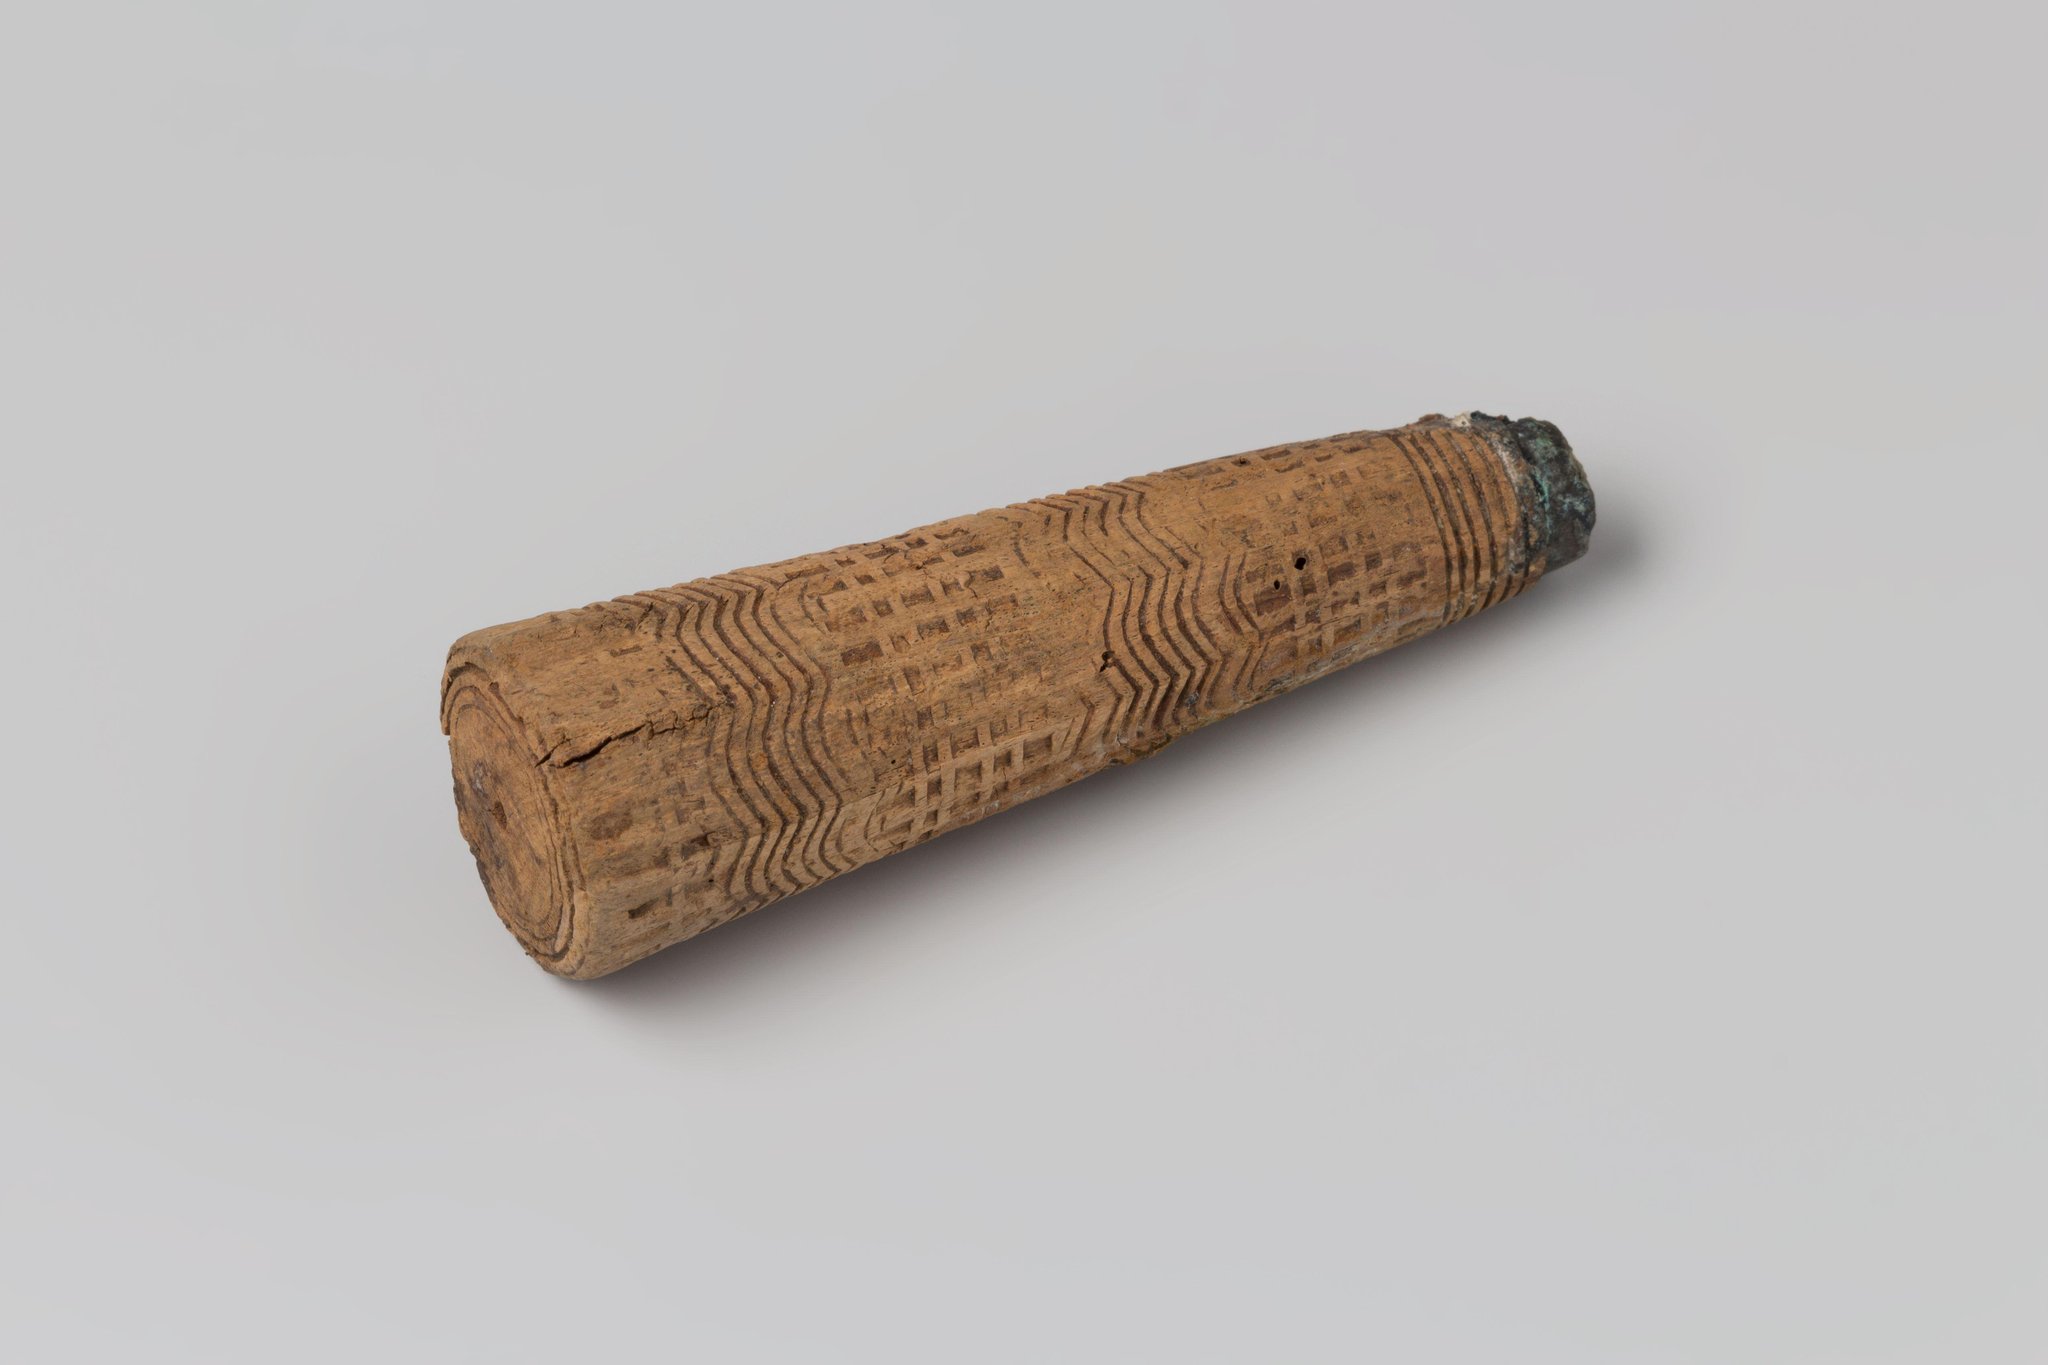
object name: knife handle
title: Messenheft uit het wrak van de Oost-Indiëvaarder Hollandia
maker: Anonymous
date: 1700-1743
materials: copper, wood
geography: netherlands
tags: verenigde oostindische compagnie, hollandia (schip), annet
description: Knife, handle, cylindrical: tapering; id. NG 1979-403H.